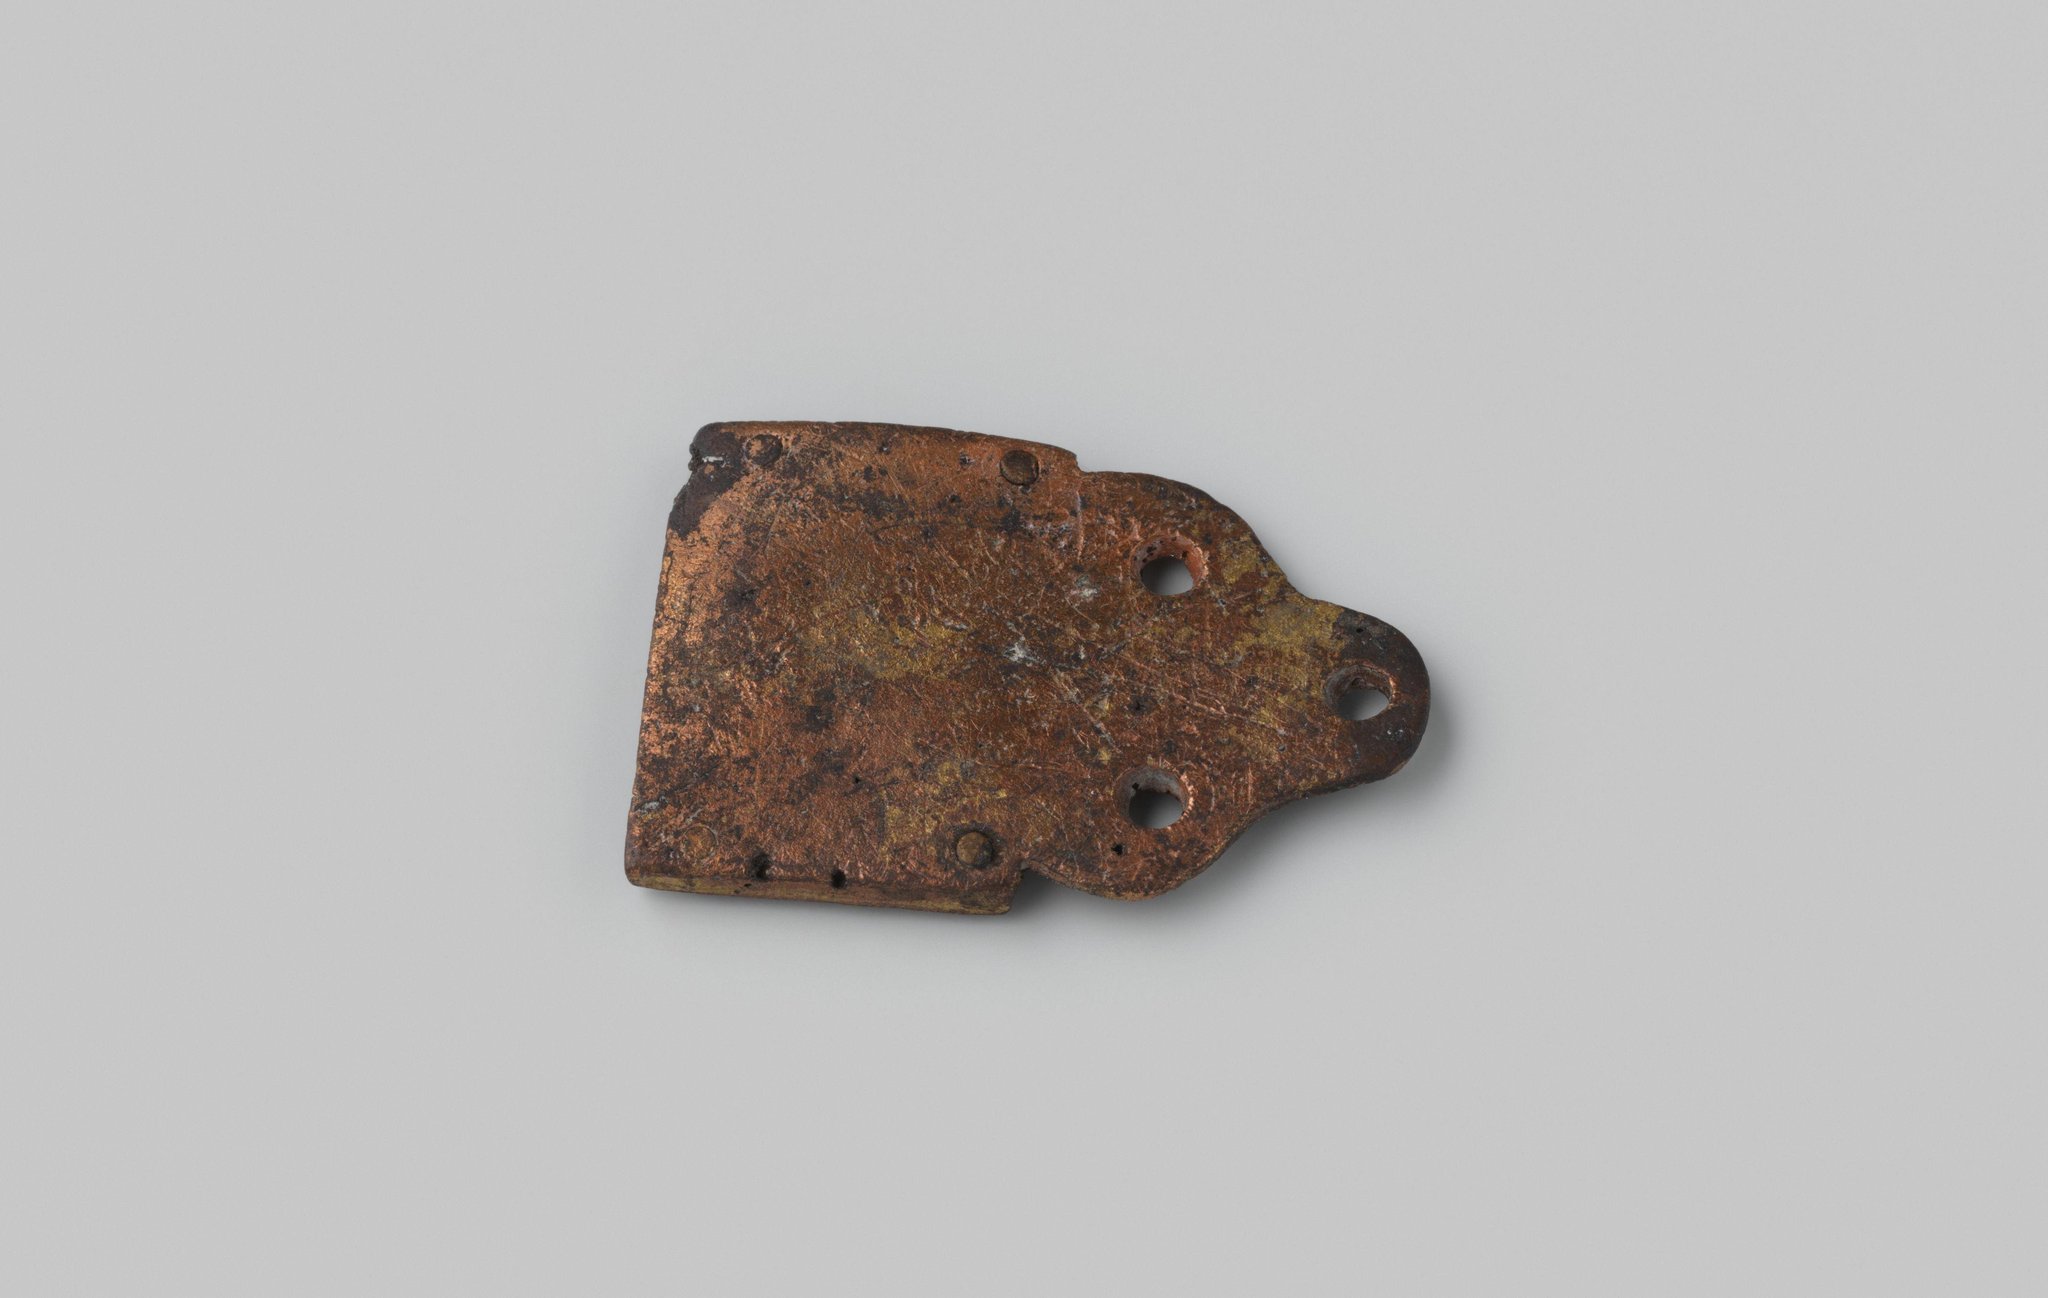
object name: lock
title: Deel van een slot uit het wrak van de Oost-Indiëvaarder Hollandia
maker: Anonymous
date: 1700-1743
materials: copper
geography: netherlands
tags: verenigde oostindische compagnie, hollandia (schip), annet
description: Locks, fastenings and accessories. lock: casings; fragm: back-plate, flat, rectangular, three-lobed upper end with 3 circular holes, raised rims on rear forming rectangular frame with 2 openings (for sliding bolt), and a small rivet in each corner, 2 pegs in centre.